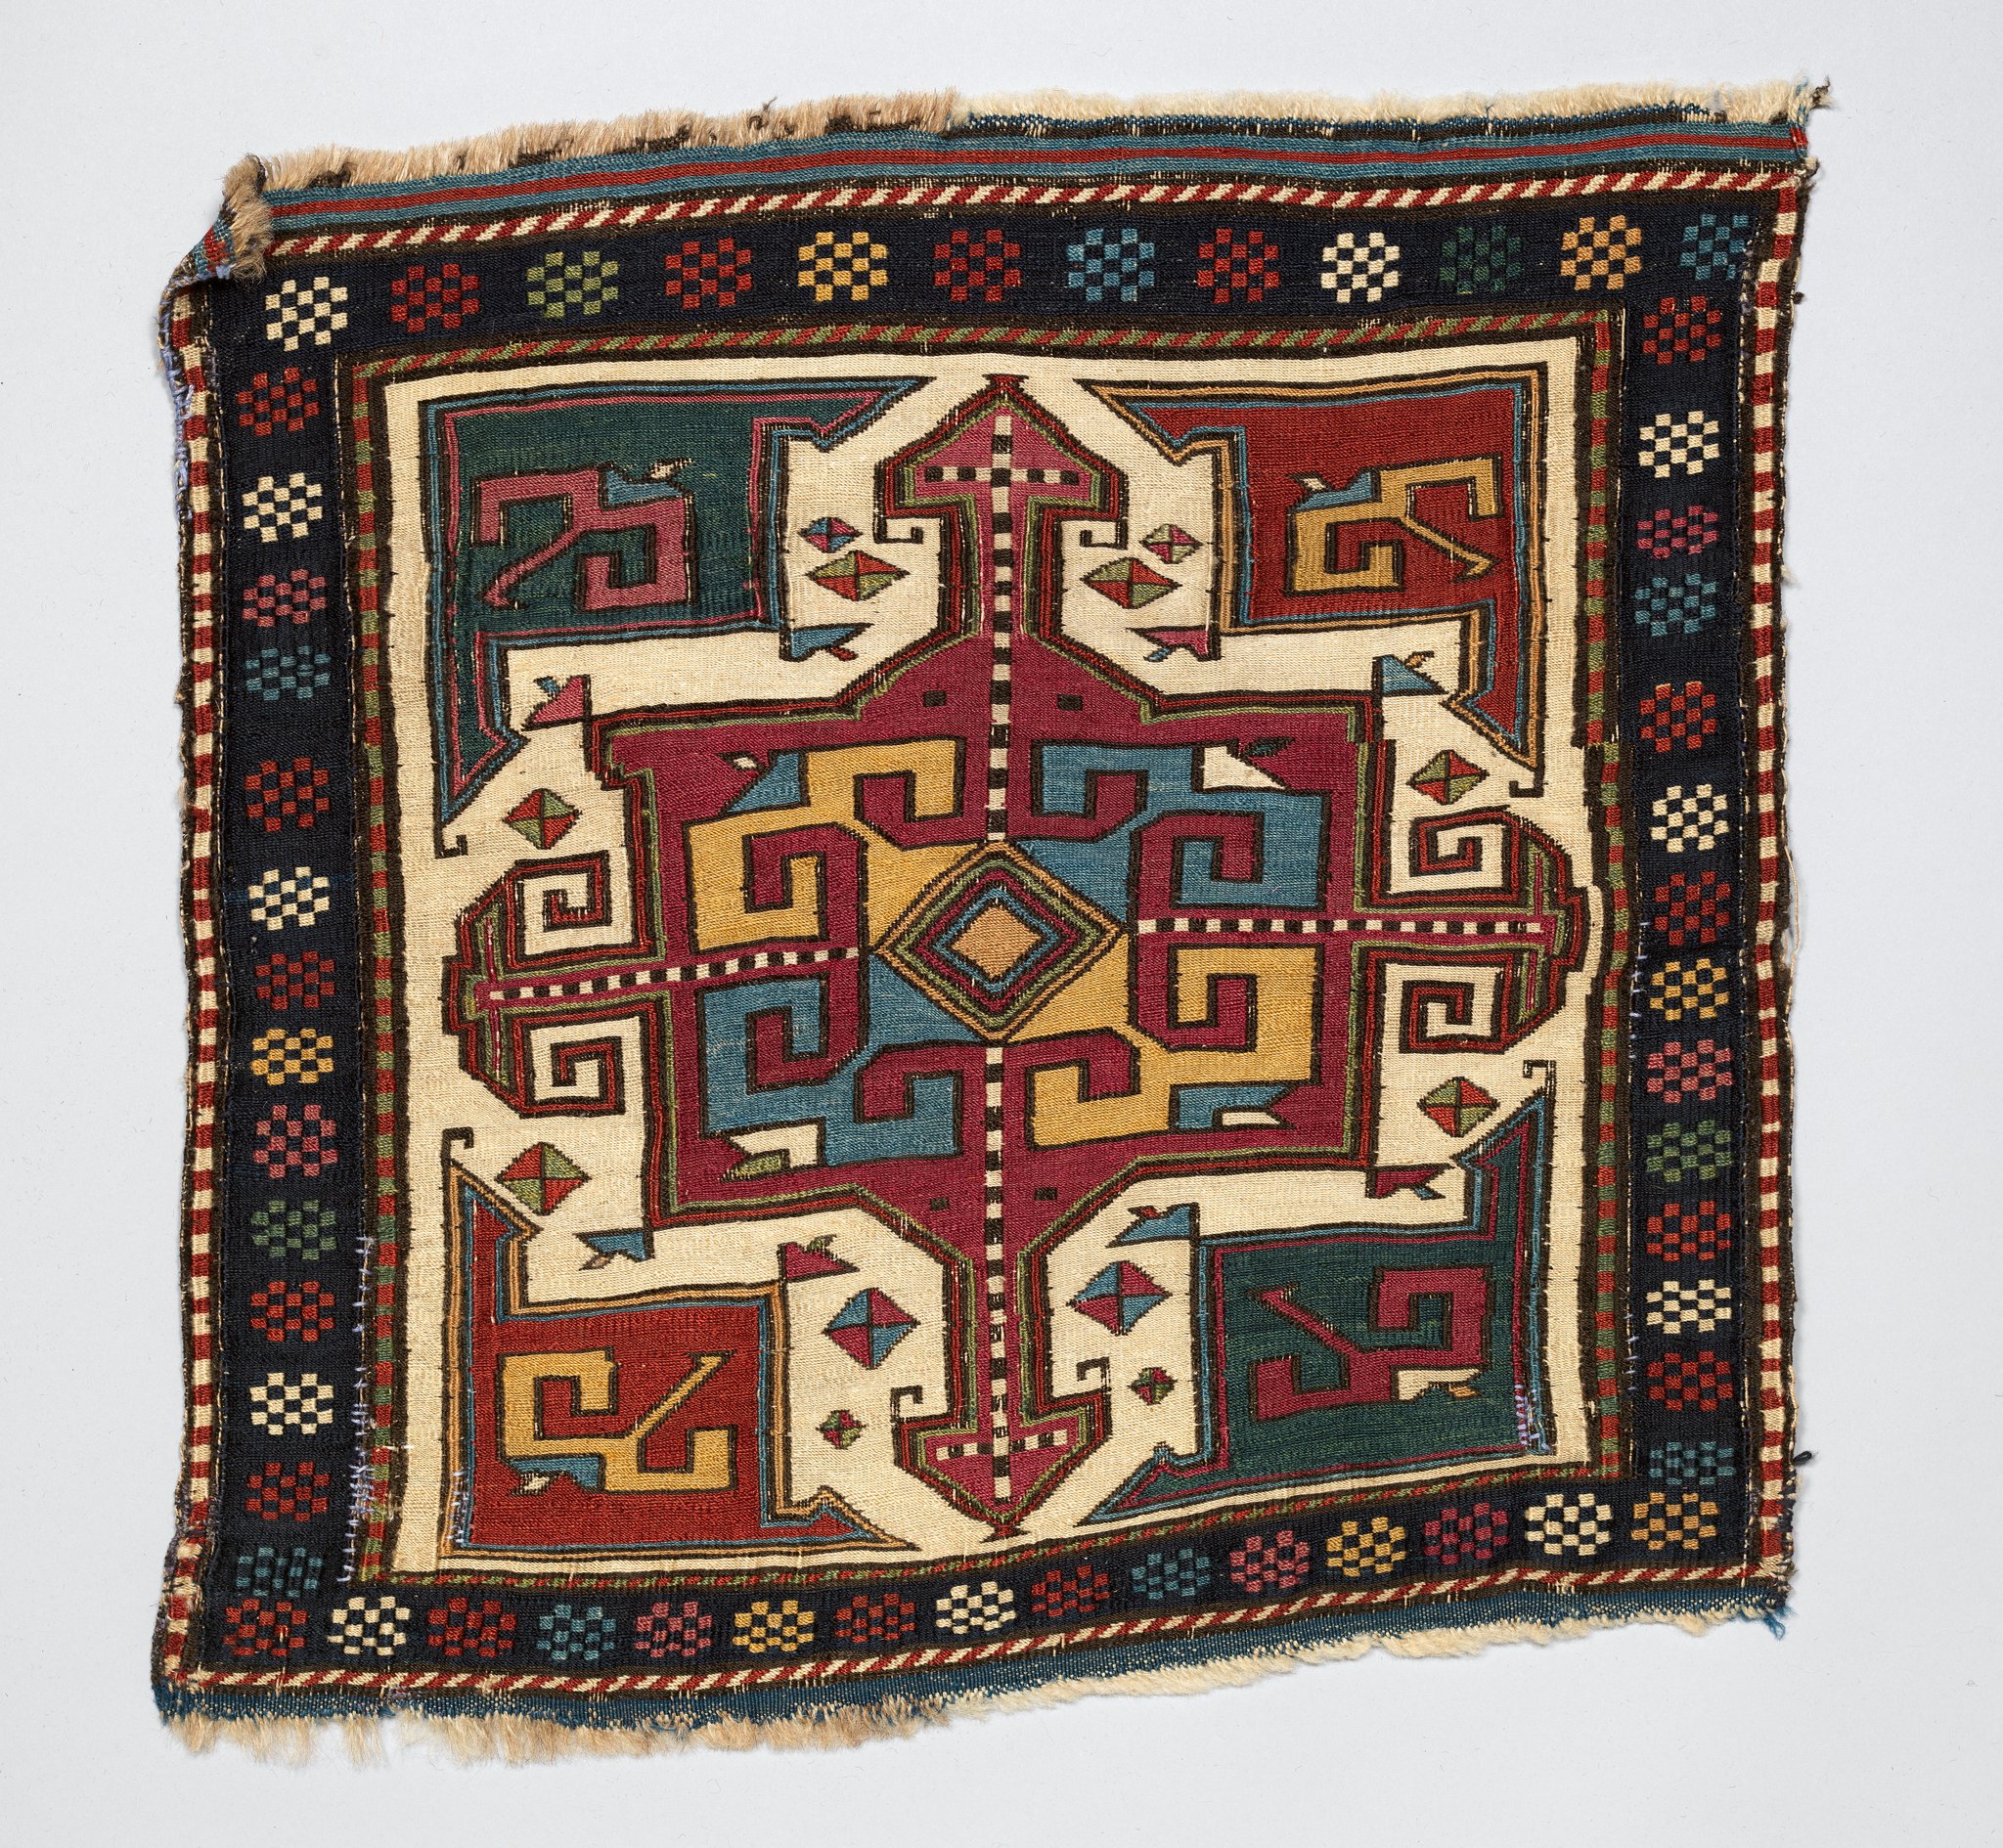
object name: saddle bag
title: Face of Half a Double Saddle Bag (Khorjin)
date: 1801-1900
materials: wool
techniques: weave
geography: iran